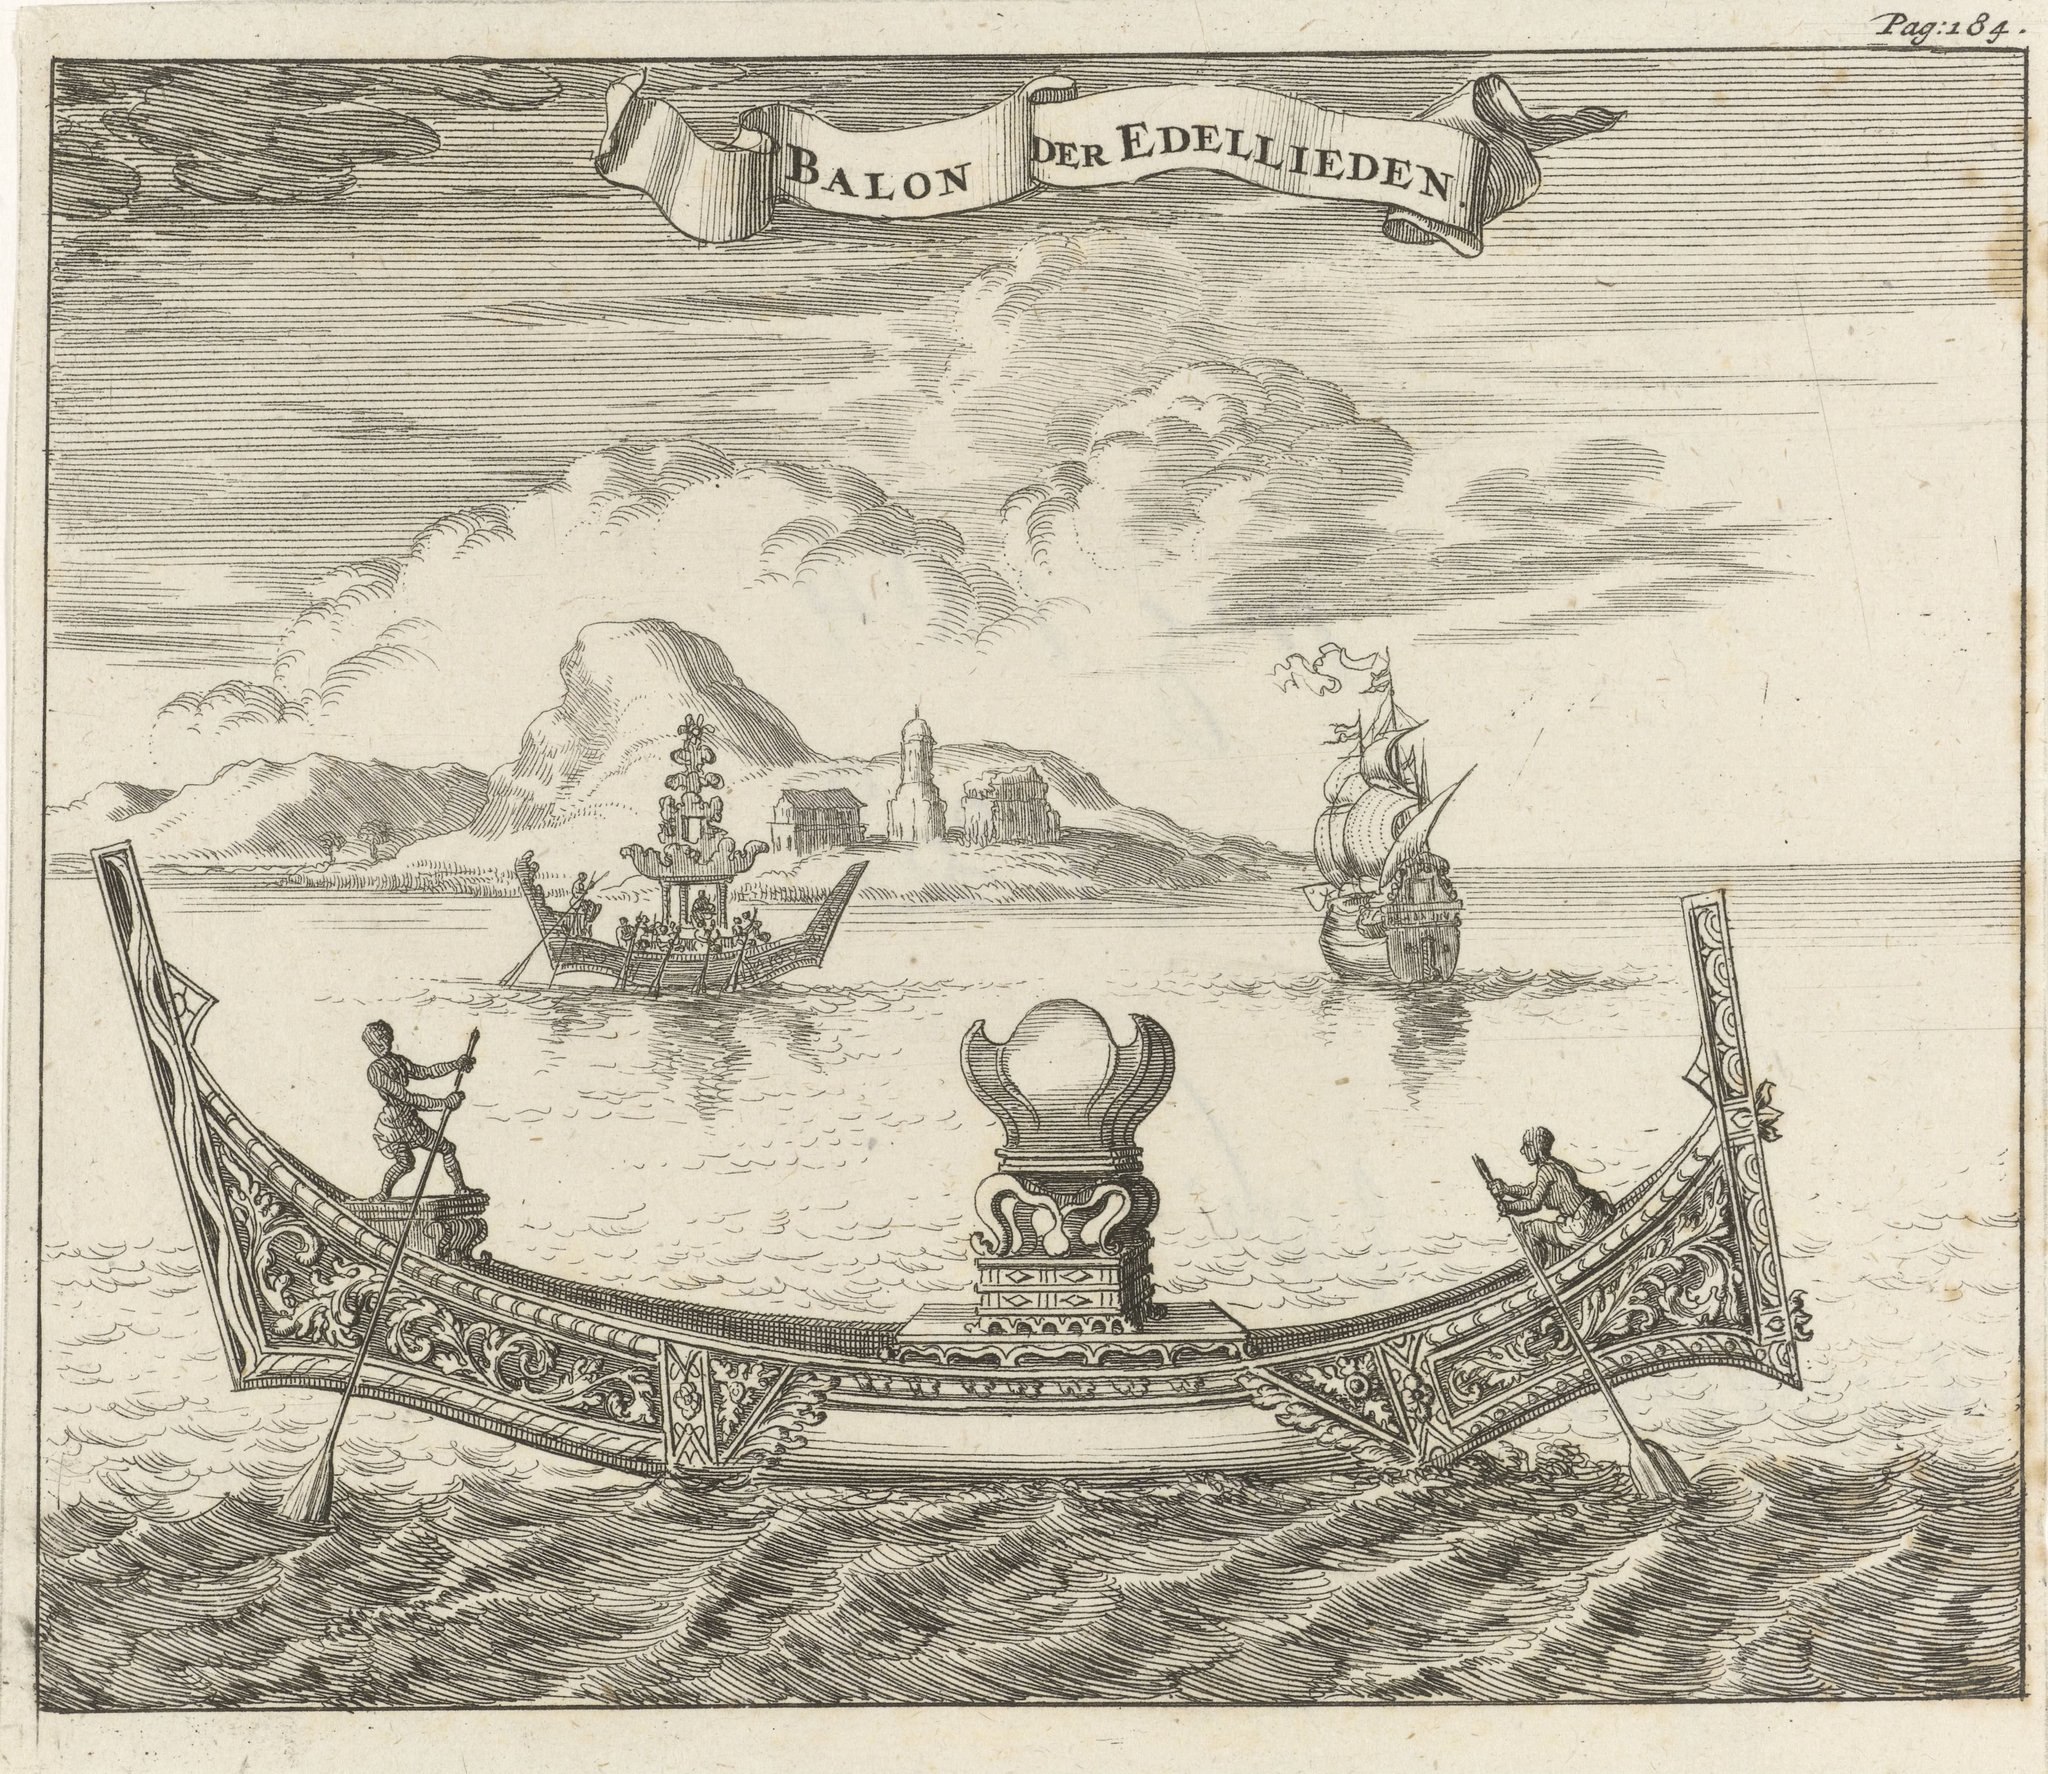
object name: print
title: Balon der Edellieden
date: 1687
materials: paper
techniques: etching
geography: amsterdam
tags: trireme, galley, thailand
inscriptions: collector's mark: Lugt 2228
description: Illustratie uit: Tachard, Guy. Reis na Siam, gedaan door den ridder de Chaumont. Amsterdam: Aart Dircksz Oossaan, 1687, p. 184.